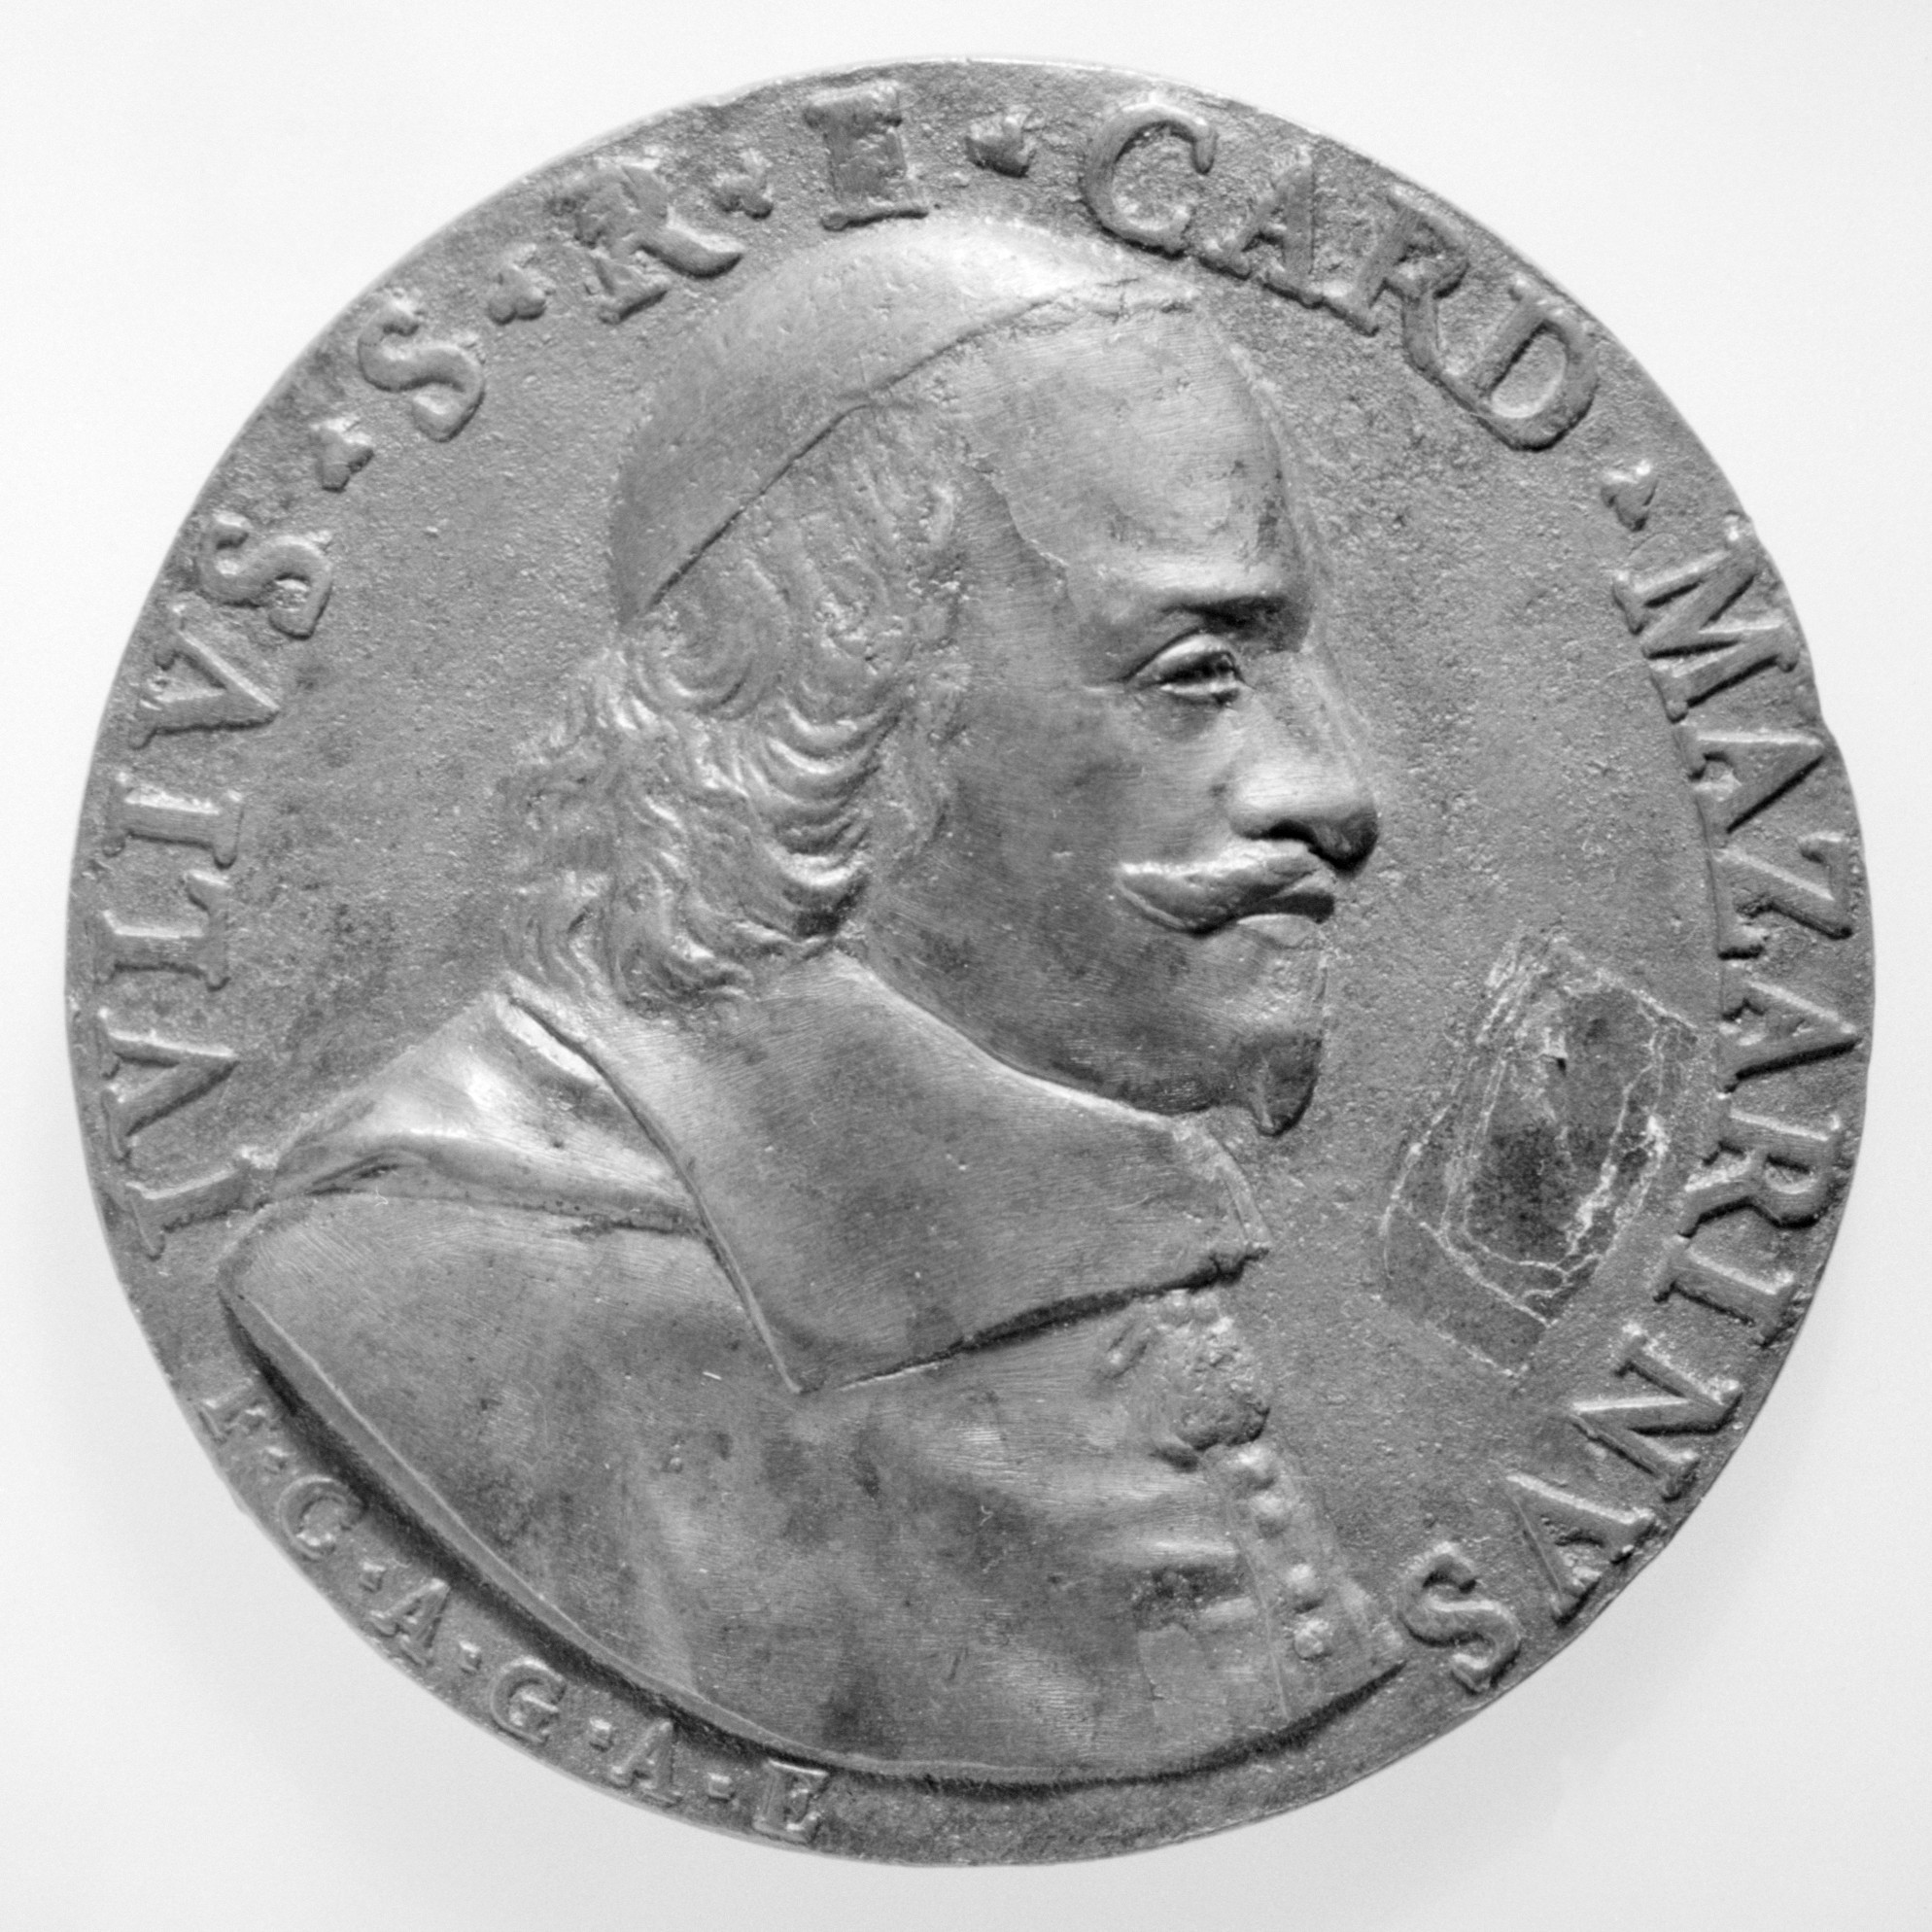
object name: medal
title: Cardinal Mazarin (1602–61)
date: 1601-1700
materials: bronze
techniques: casting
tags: men,profiles